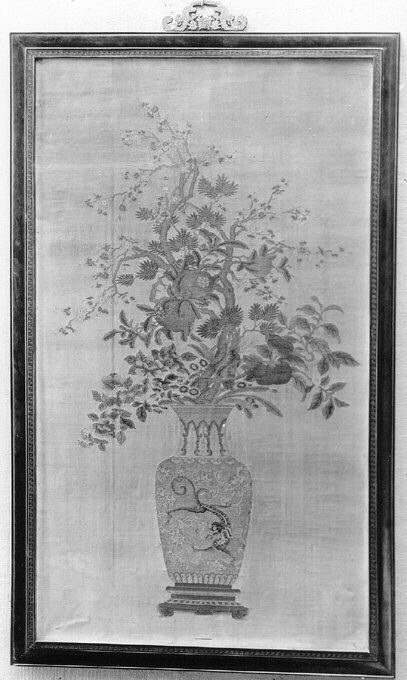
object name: panel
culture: chinese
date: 1736-1795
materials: silk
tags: plants